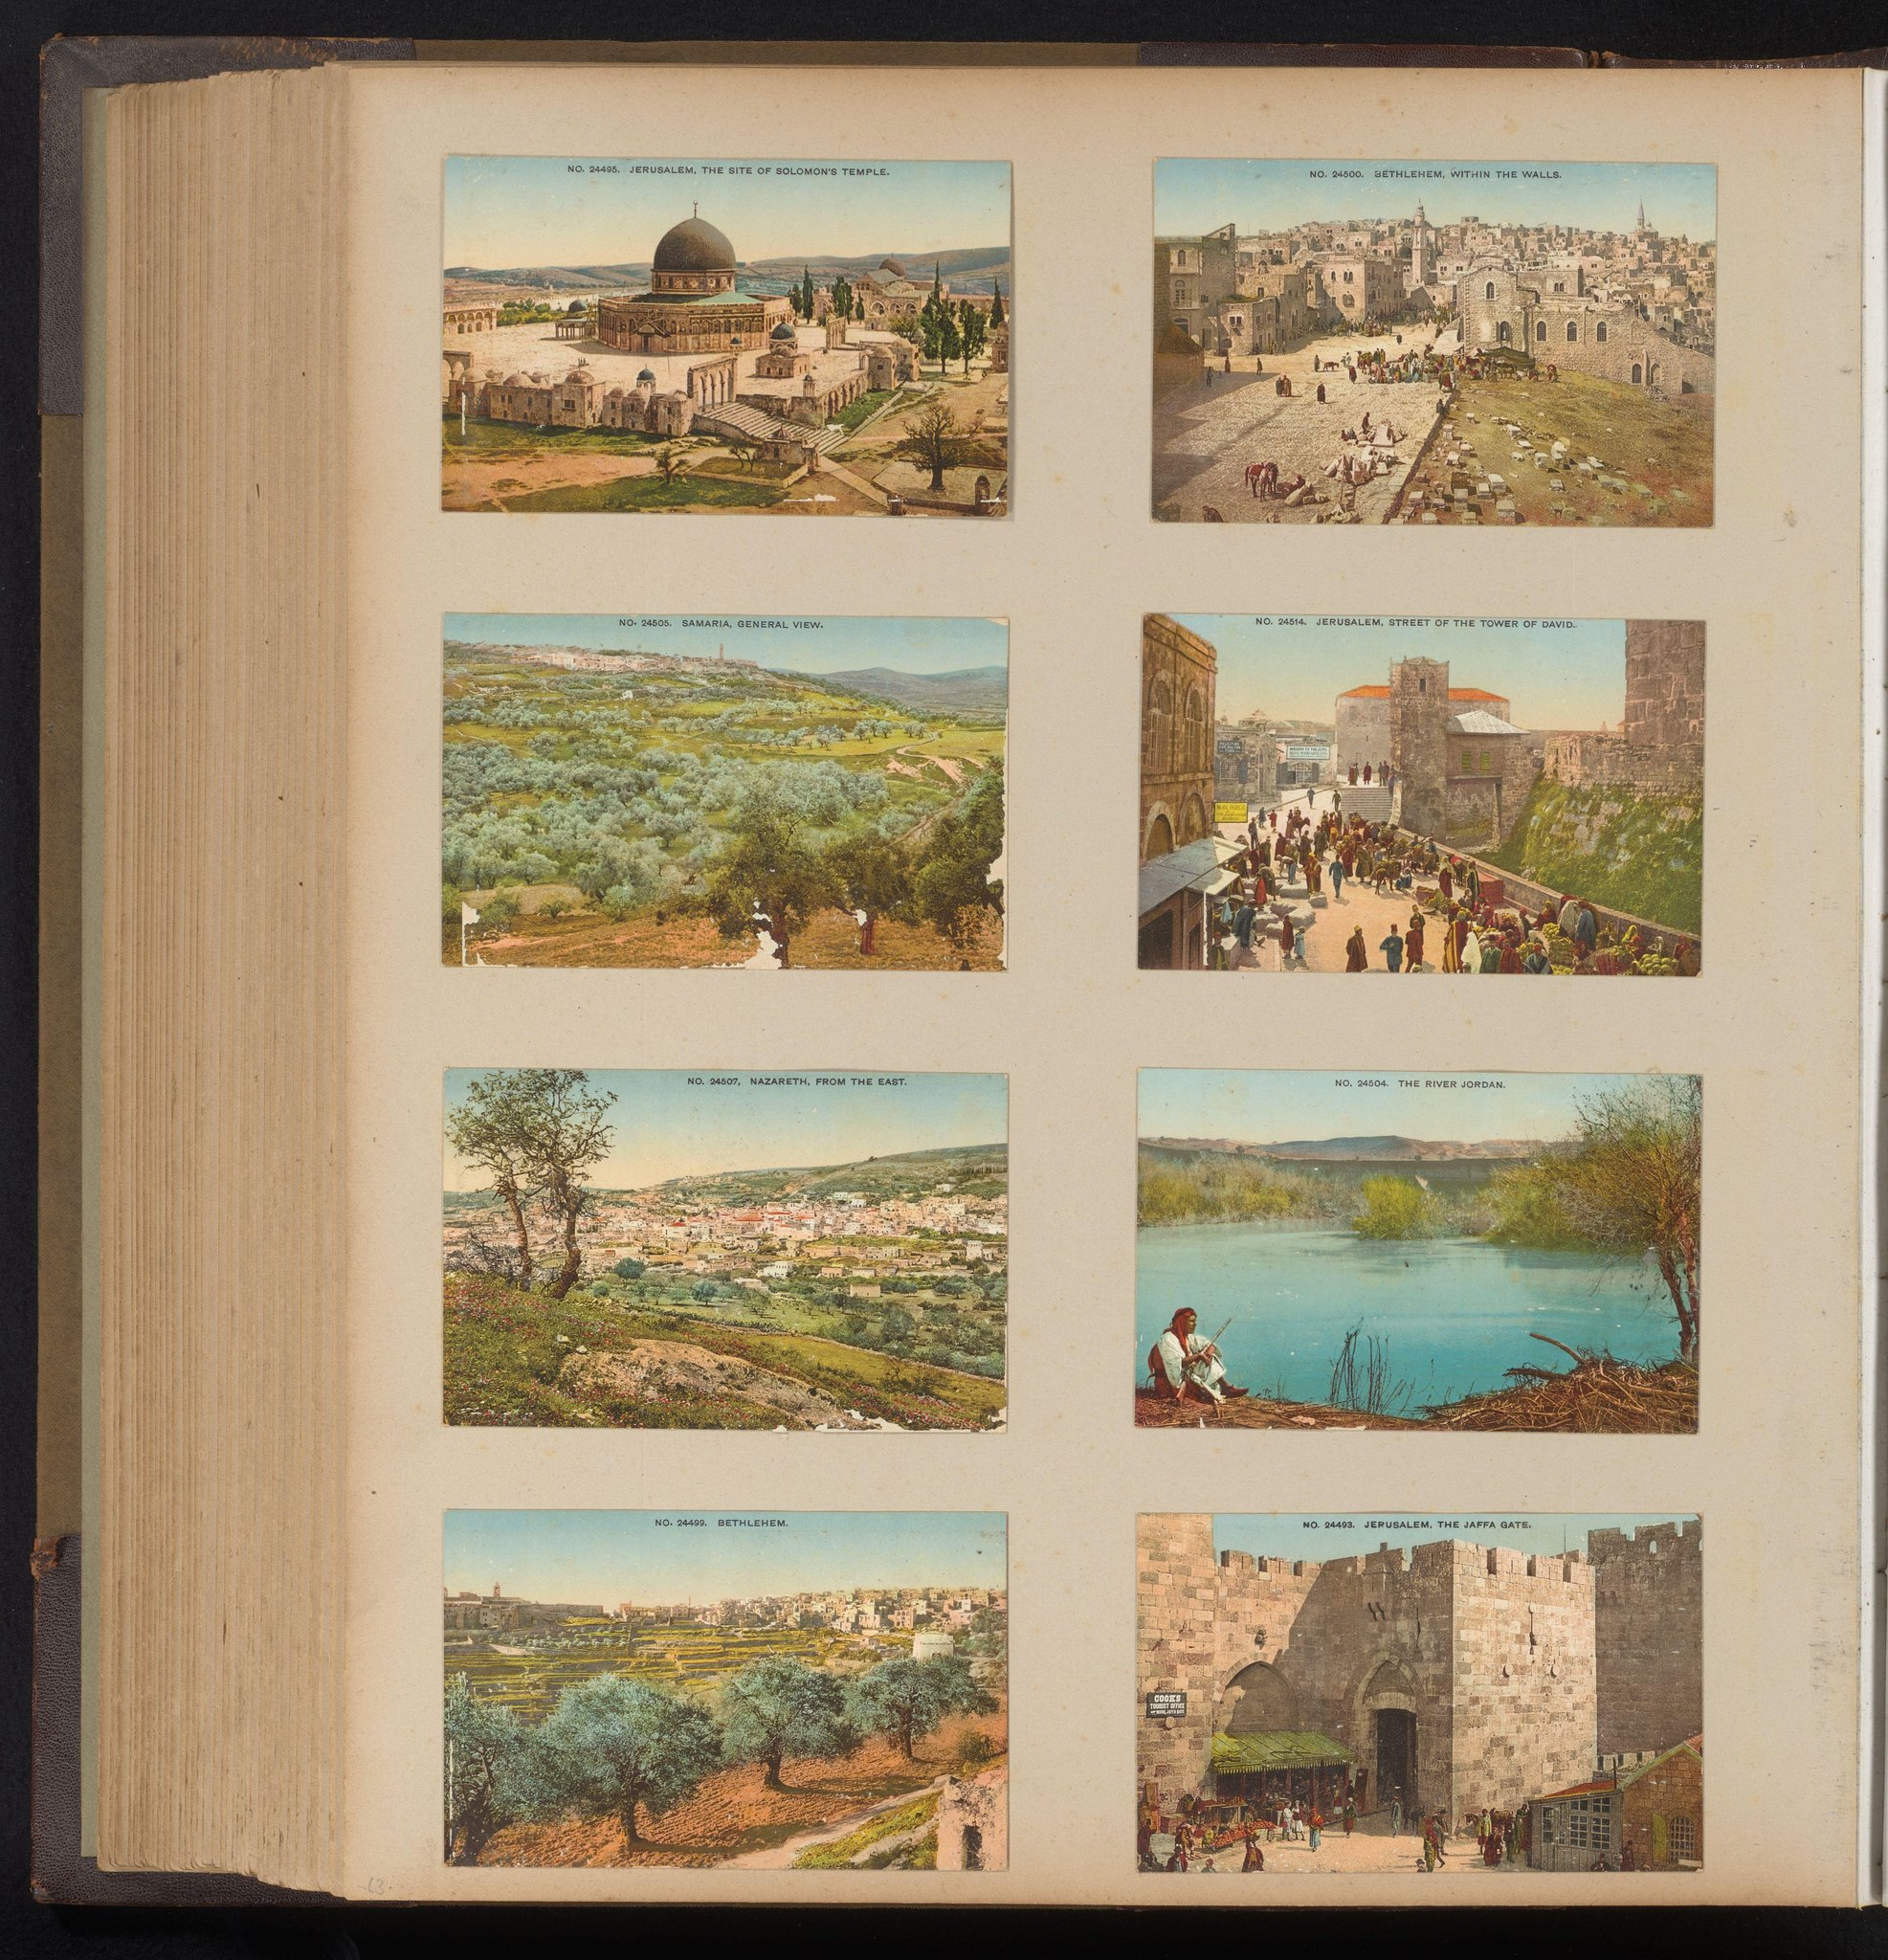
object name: ansichtkaart, prentbriefkaart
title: Acht prentbriefkaarten met gezichten op Jeruzalem, Bethlehem, Nazareth en Samaria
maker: Anonymous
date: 1871-1910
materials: paper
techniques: photolithography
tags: city-view in general; 'veduta'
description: Deze prent maakt deel uit van een album.